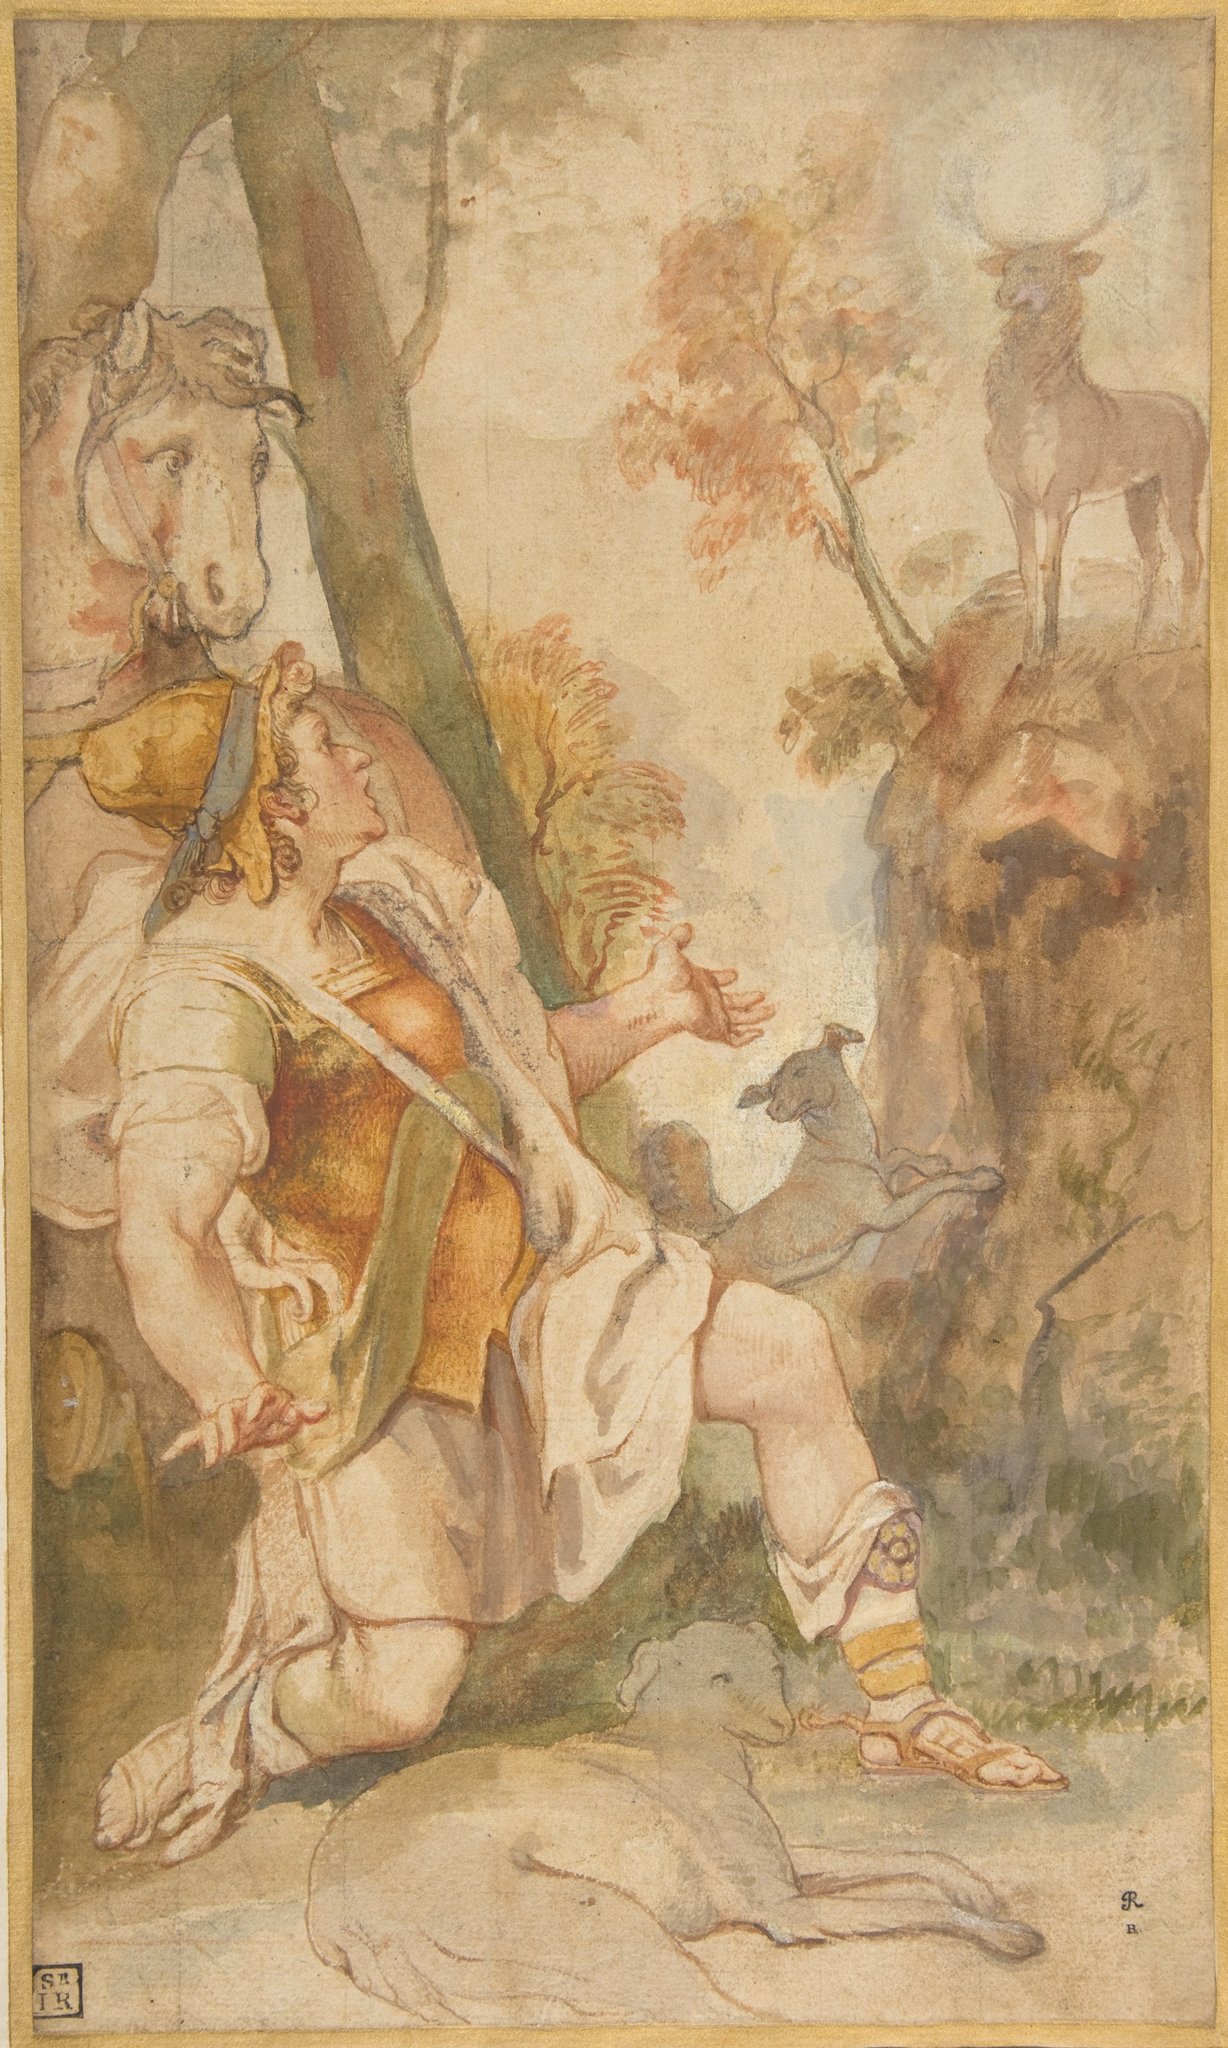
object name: drawing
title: The Vision of Saint Eustace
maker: federico zuccaro (zuccari)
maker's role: artist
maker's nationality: italian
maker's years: 1540-1609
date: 1542-1609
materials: chalk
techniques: brush, highlighting, drawing, wash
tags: men,deer,dogs,horses,saints